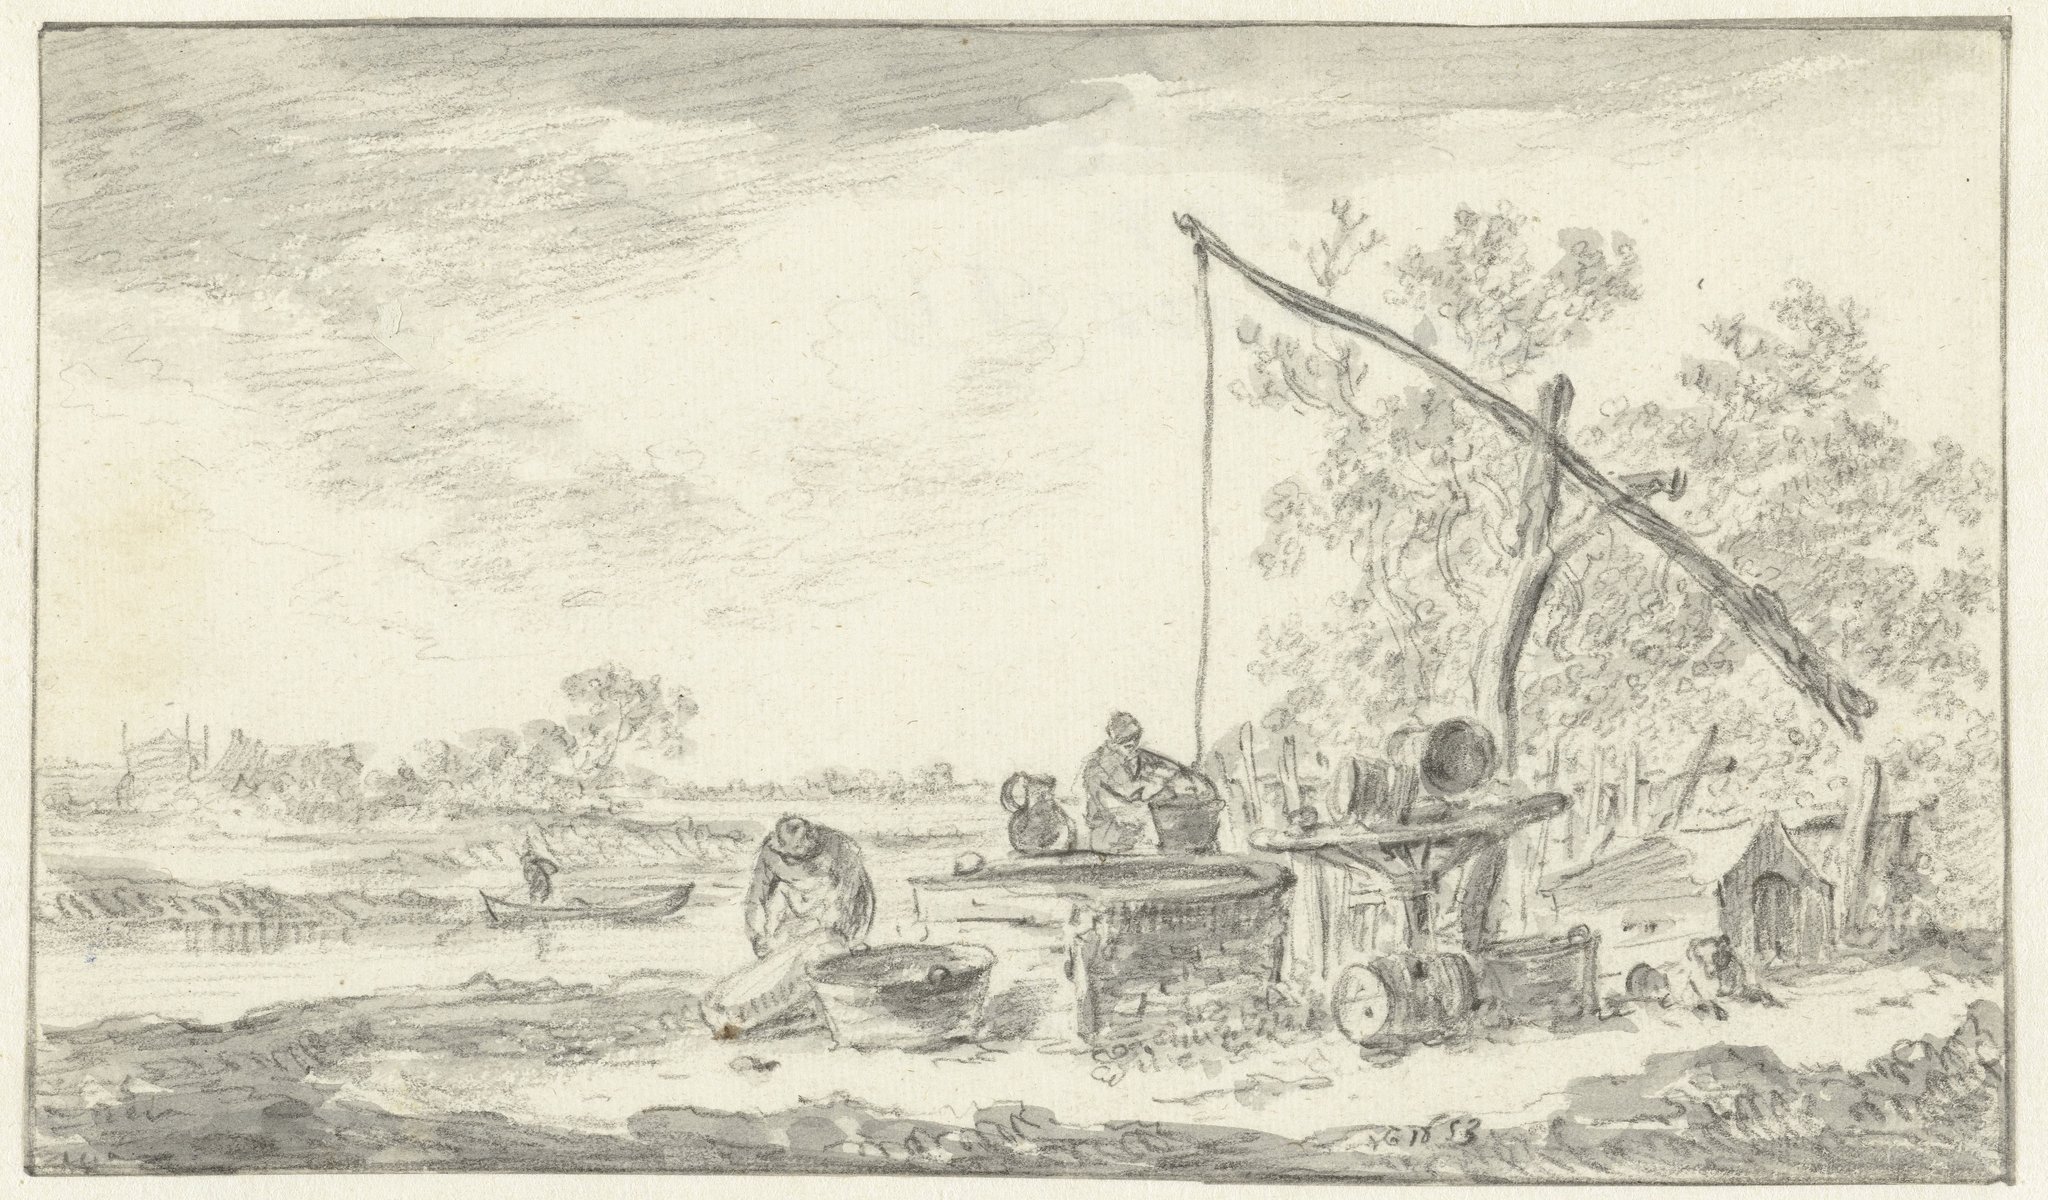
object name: drawing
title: Twee figuren bij een waterput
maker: jan van goyen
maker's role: draughtsman, painter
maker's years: 1596-1656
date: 1653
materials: chalk, paper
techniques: brush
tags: well